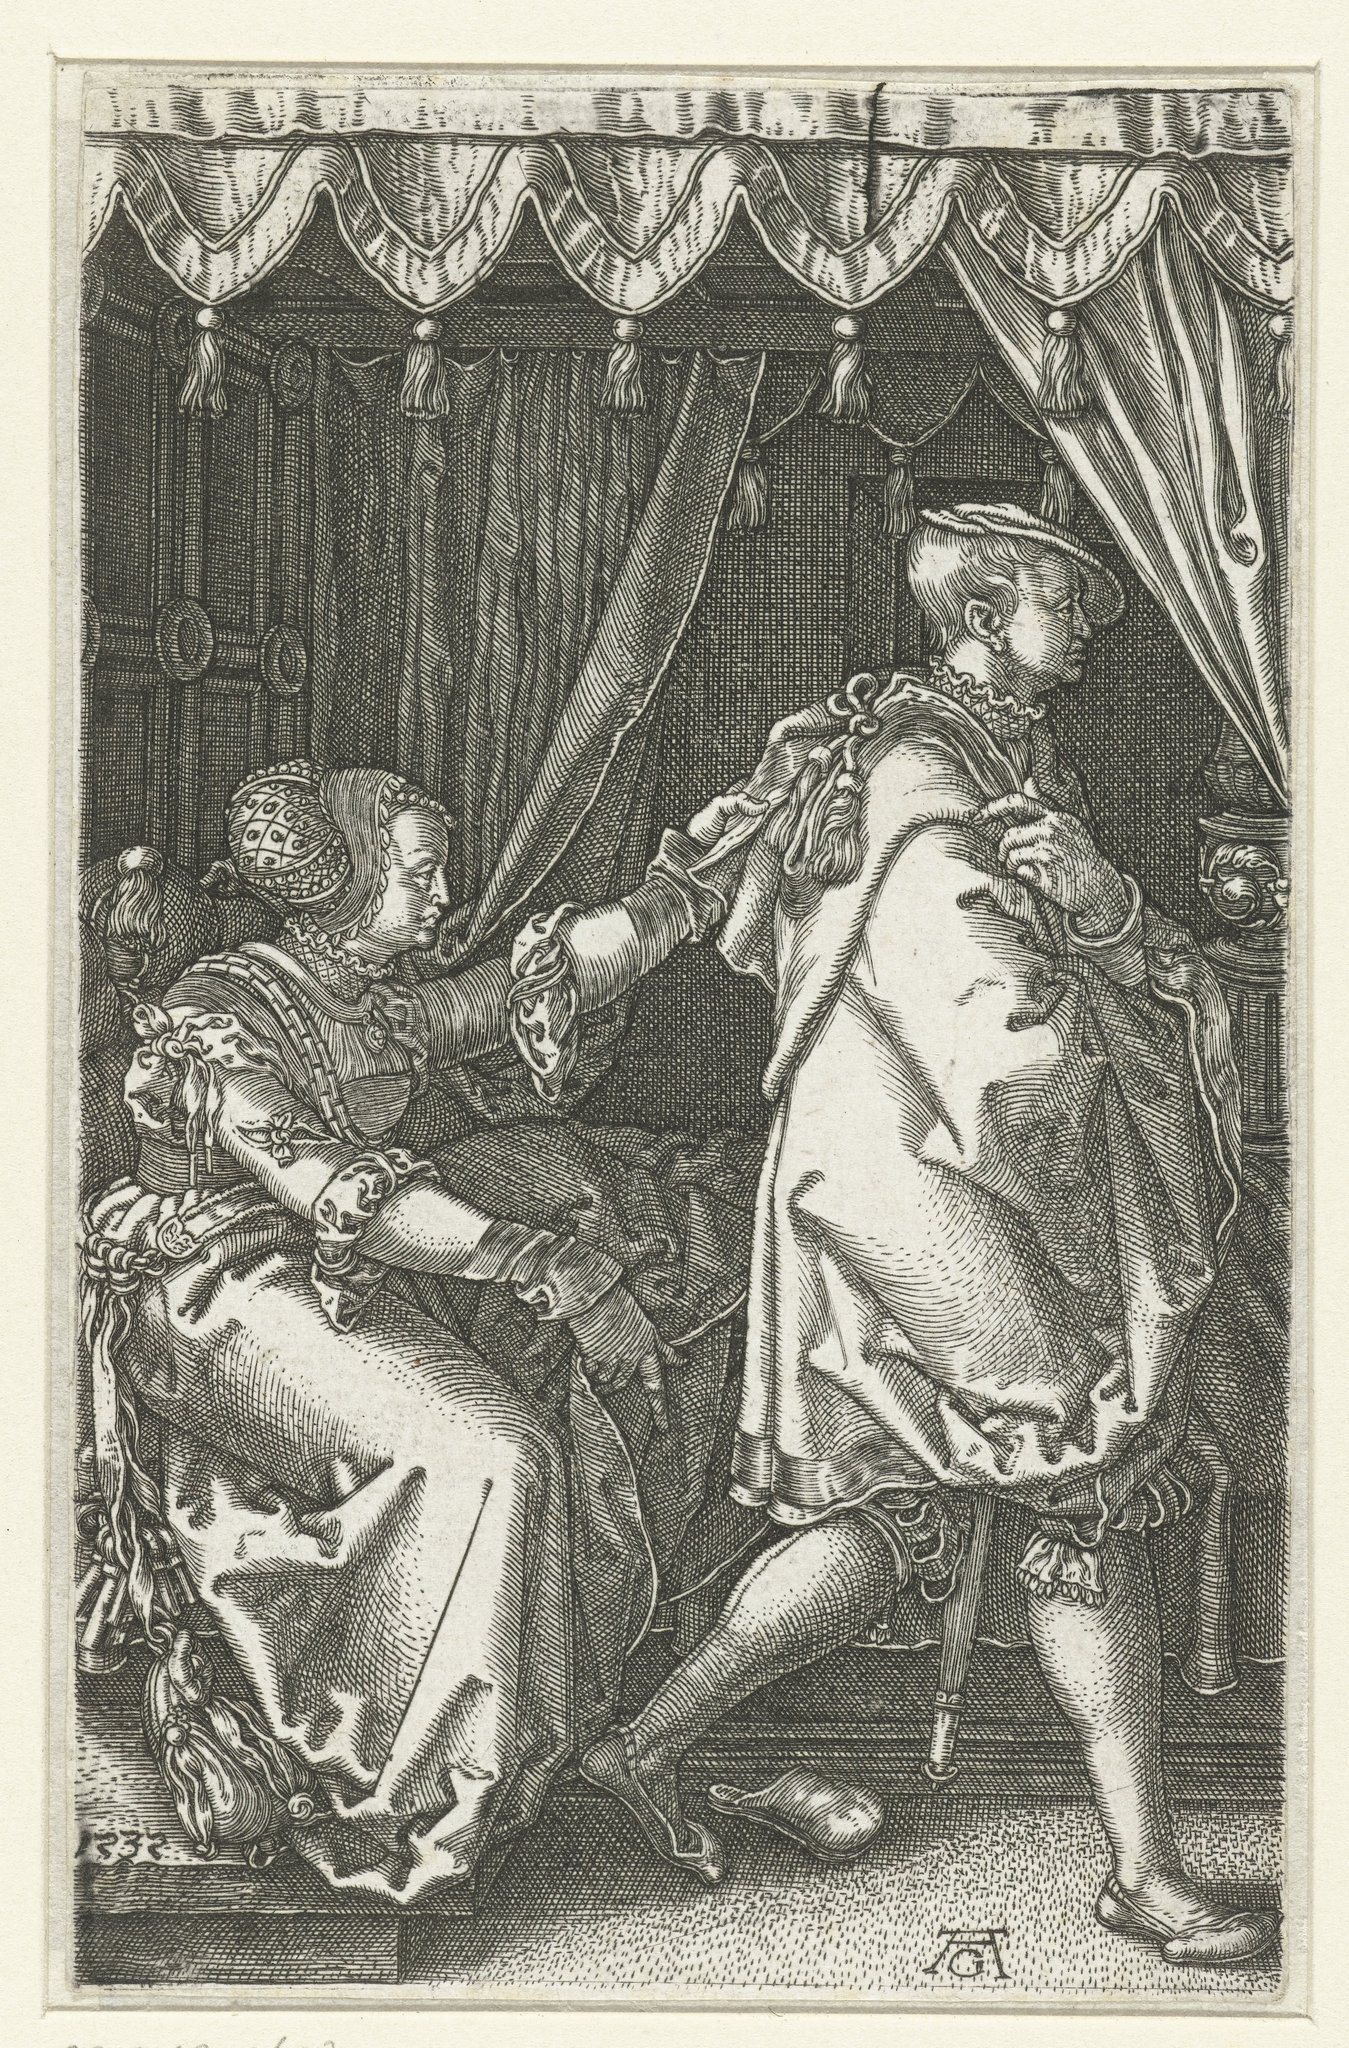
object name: print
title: Jozef en de vrouw van Potifar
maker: heinrich aldegrever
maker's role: draughtsman, print maker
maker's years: 1502-1561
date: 1532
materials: paper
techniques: engraving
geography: germany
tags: potiphar's wife catches joseph by his robe, usually while lying in bed; joseph escapes leaving his cloak behind in her hands (possibly with a naked child lying in a crib)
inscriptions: date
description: Jozef in het slaapvertrek, loopt weg van de vrouw van Potifar. Zij pakt zijn mantel beet. Tweede prent van drie met het verhaal van Jozef .